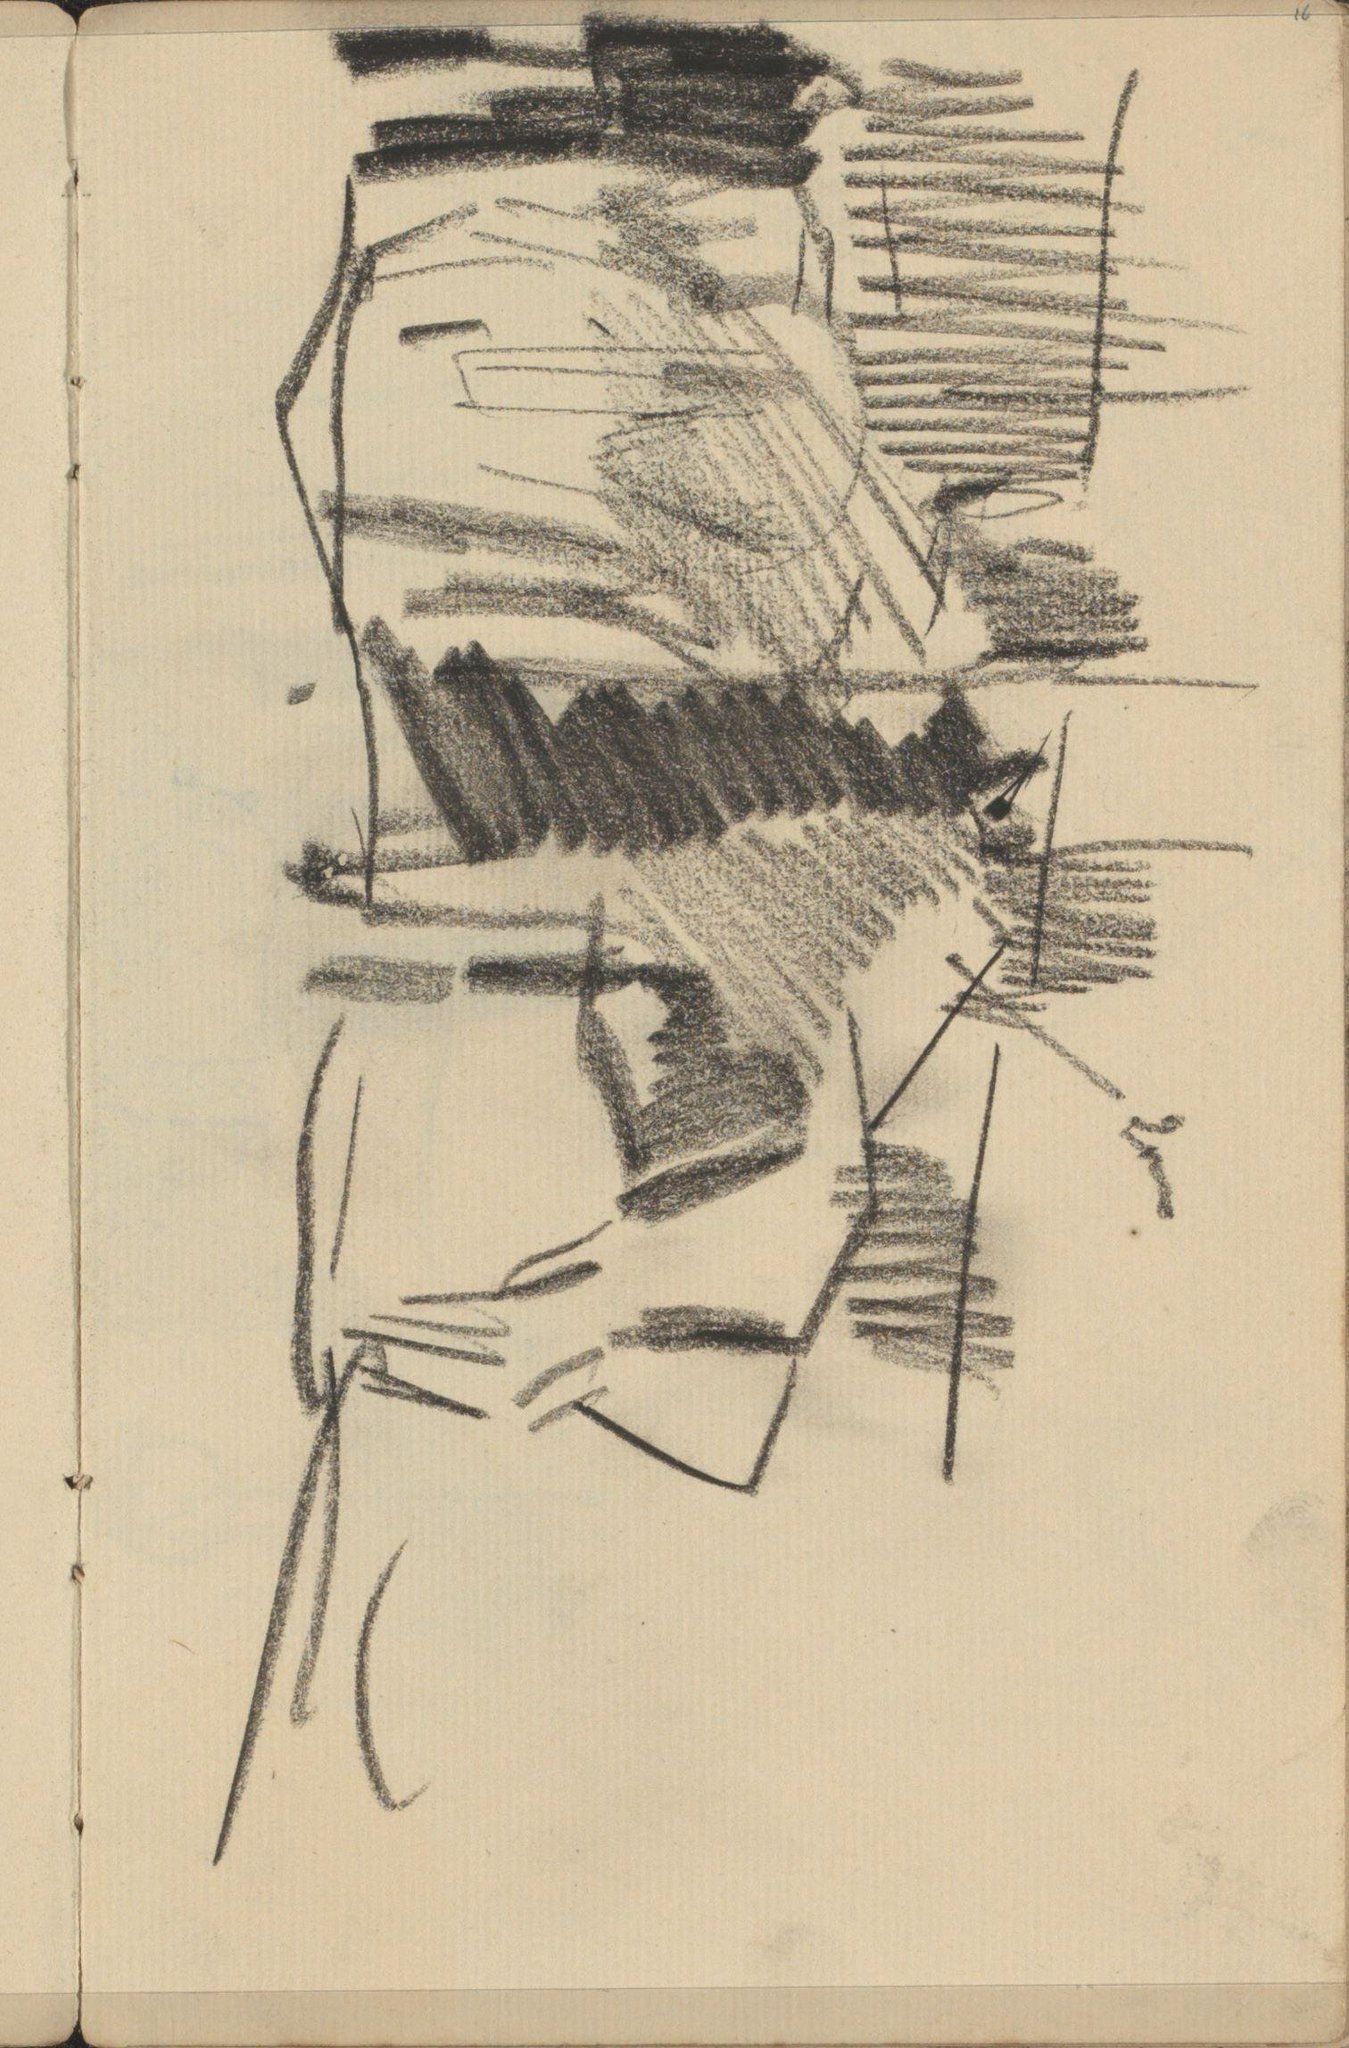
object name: sketchbook leaf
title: Paarden, mogelijk bij een voederplaats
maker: george hendrik breitner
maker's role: draughtsman, painter, print maker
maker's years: 1857-1923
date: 1882-1884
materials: chalk, paper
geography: the hague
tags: horse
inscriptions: kleurnotitie, handgeschreven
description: Pagina 16 uit een schetsboek met 24 bladen.